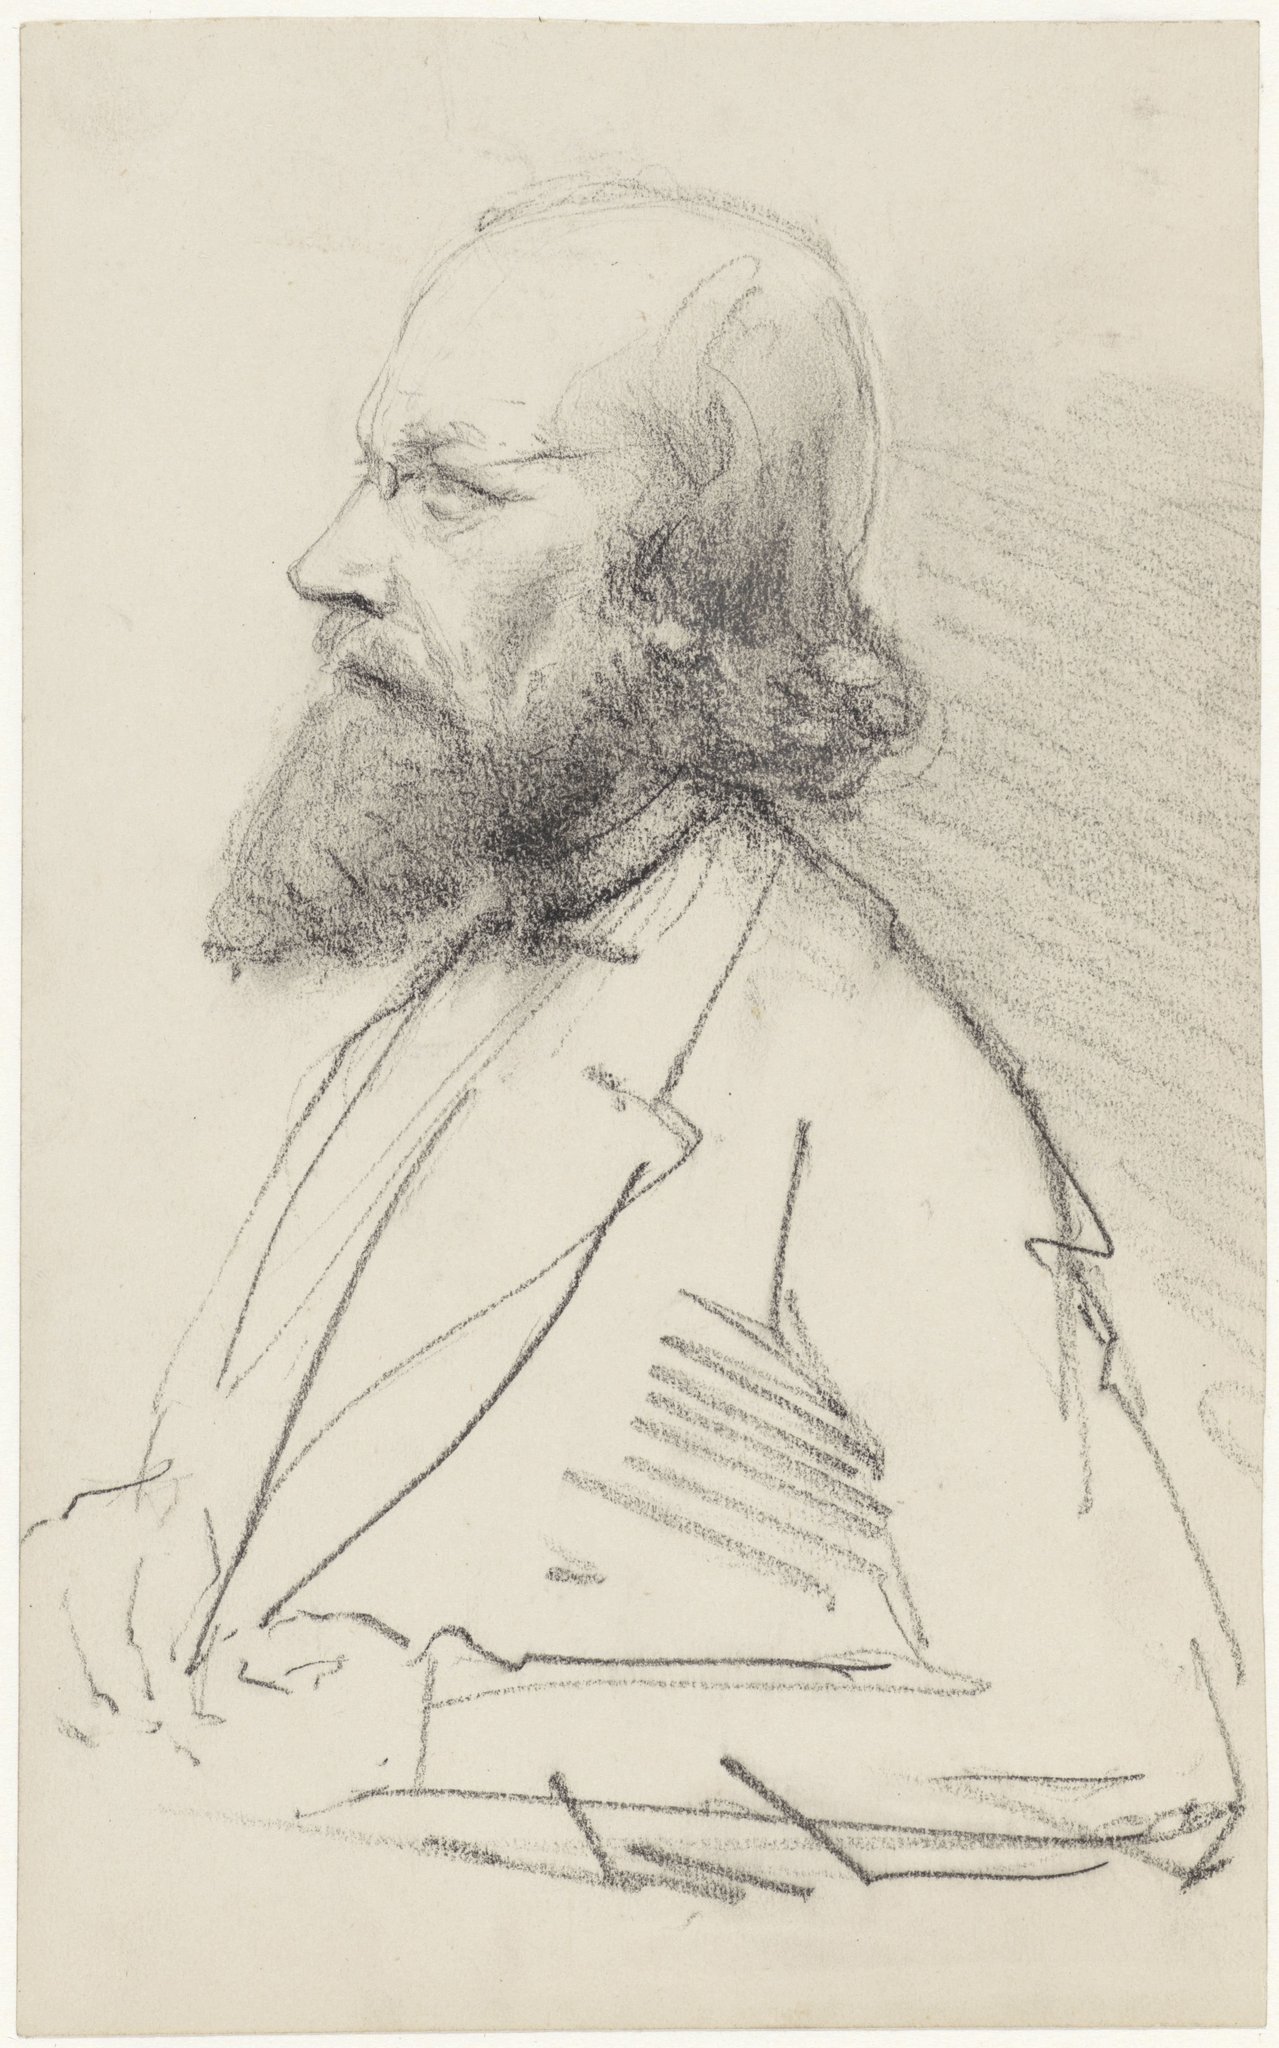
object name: drawing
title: Portret van P.J.H. Cuypers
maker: a.a.l. de grammont-hubrecht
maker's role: draughtsman, painter, print maker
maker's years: 1855-1913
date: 1865-1913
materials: chalk, paper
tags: draughtsman, pierre joseph hubert cuypers, historical persons, portrait, self-portrait of architect